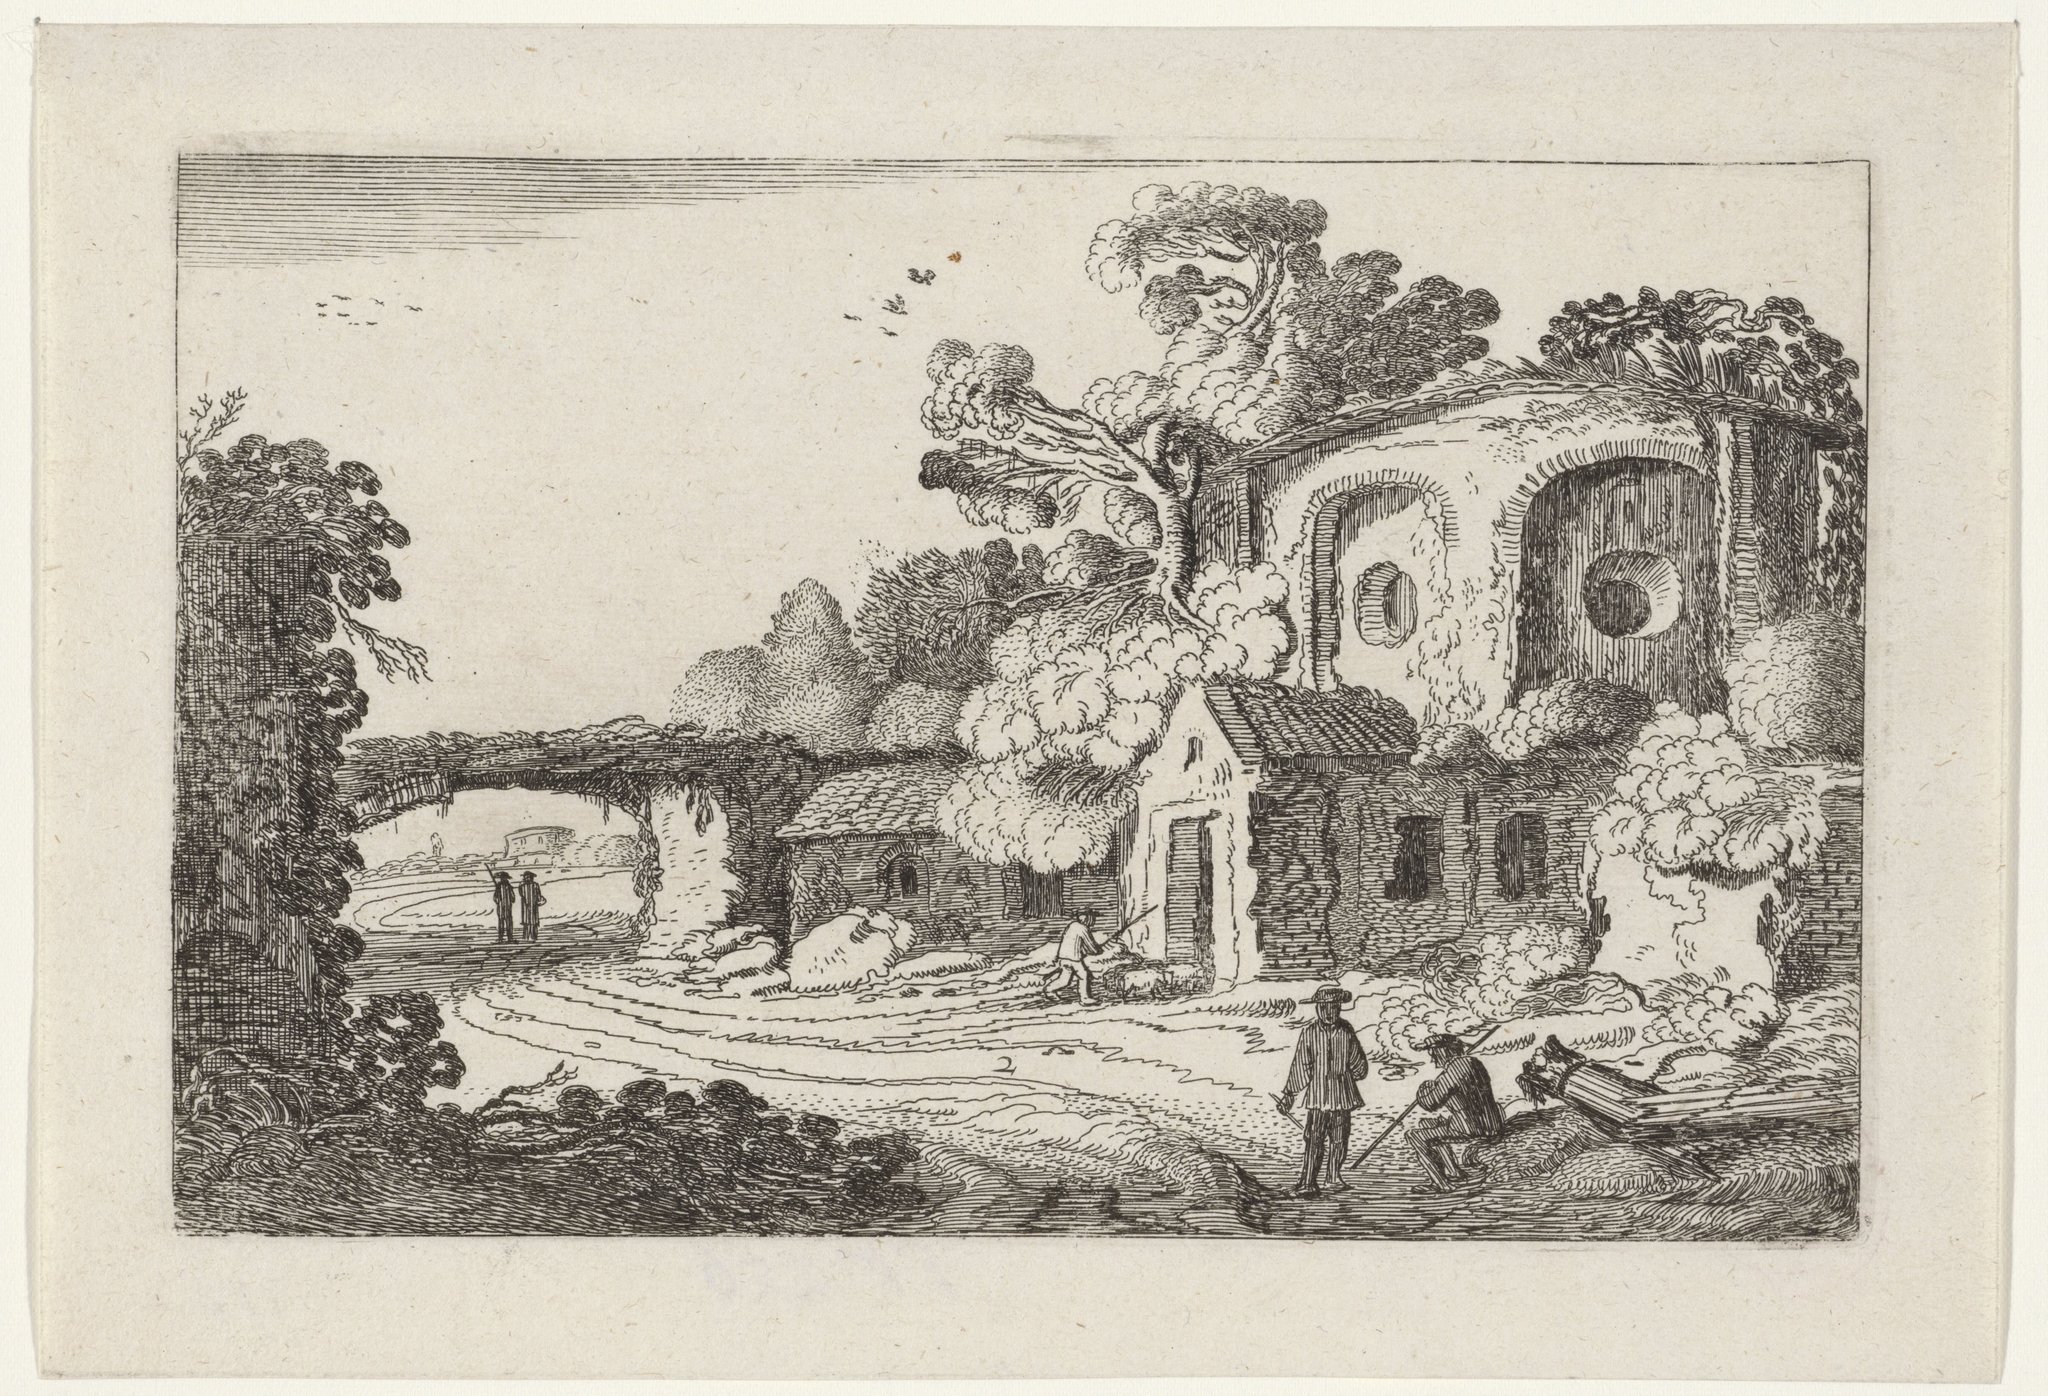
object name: print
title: Ruïnes in landschappen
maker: jan van de velde (ii)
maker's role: draughtsman, painter, print maker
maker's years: 1593-1641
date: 1616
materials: paper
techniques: etching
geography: northern netherlands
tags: landscape with ruins, ruin of a dwelling, house, castle, etc.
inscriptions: collector's mark: Lugt 240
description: Figuren bij een ruïne van een burcht, die is begroeid met bomen en struiken. Tweede prent van een serie van zestien.